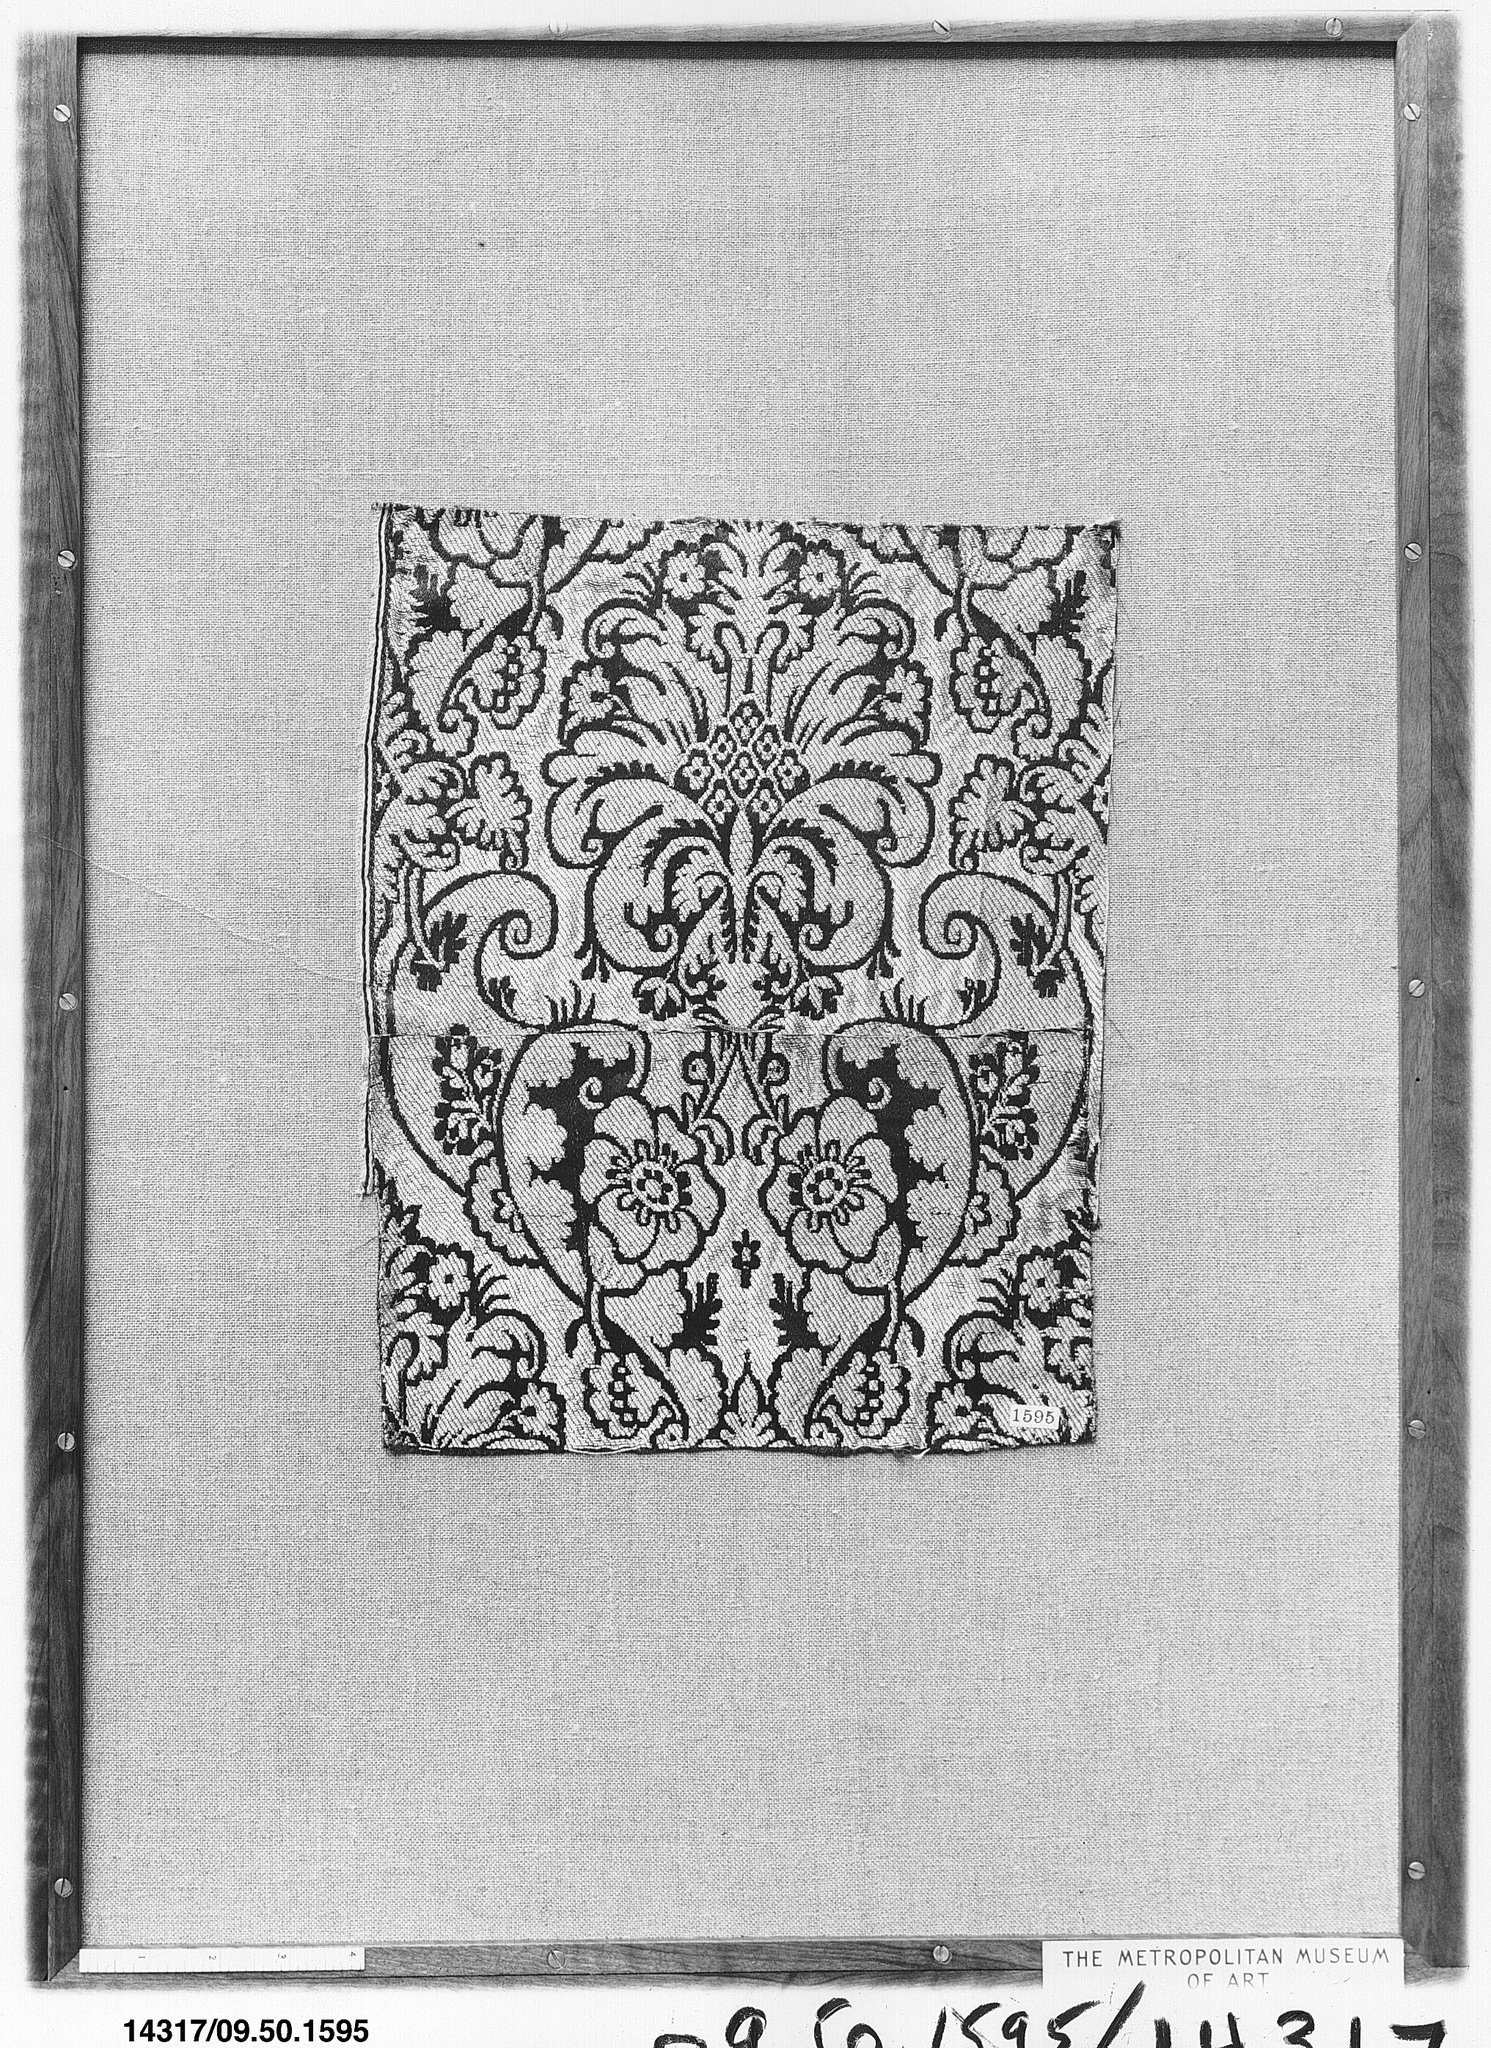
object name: piece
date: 1601-1700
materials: silk